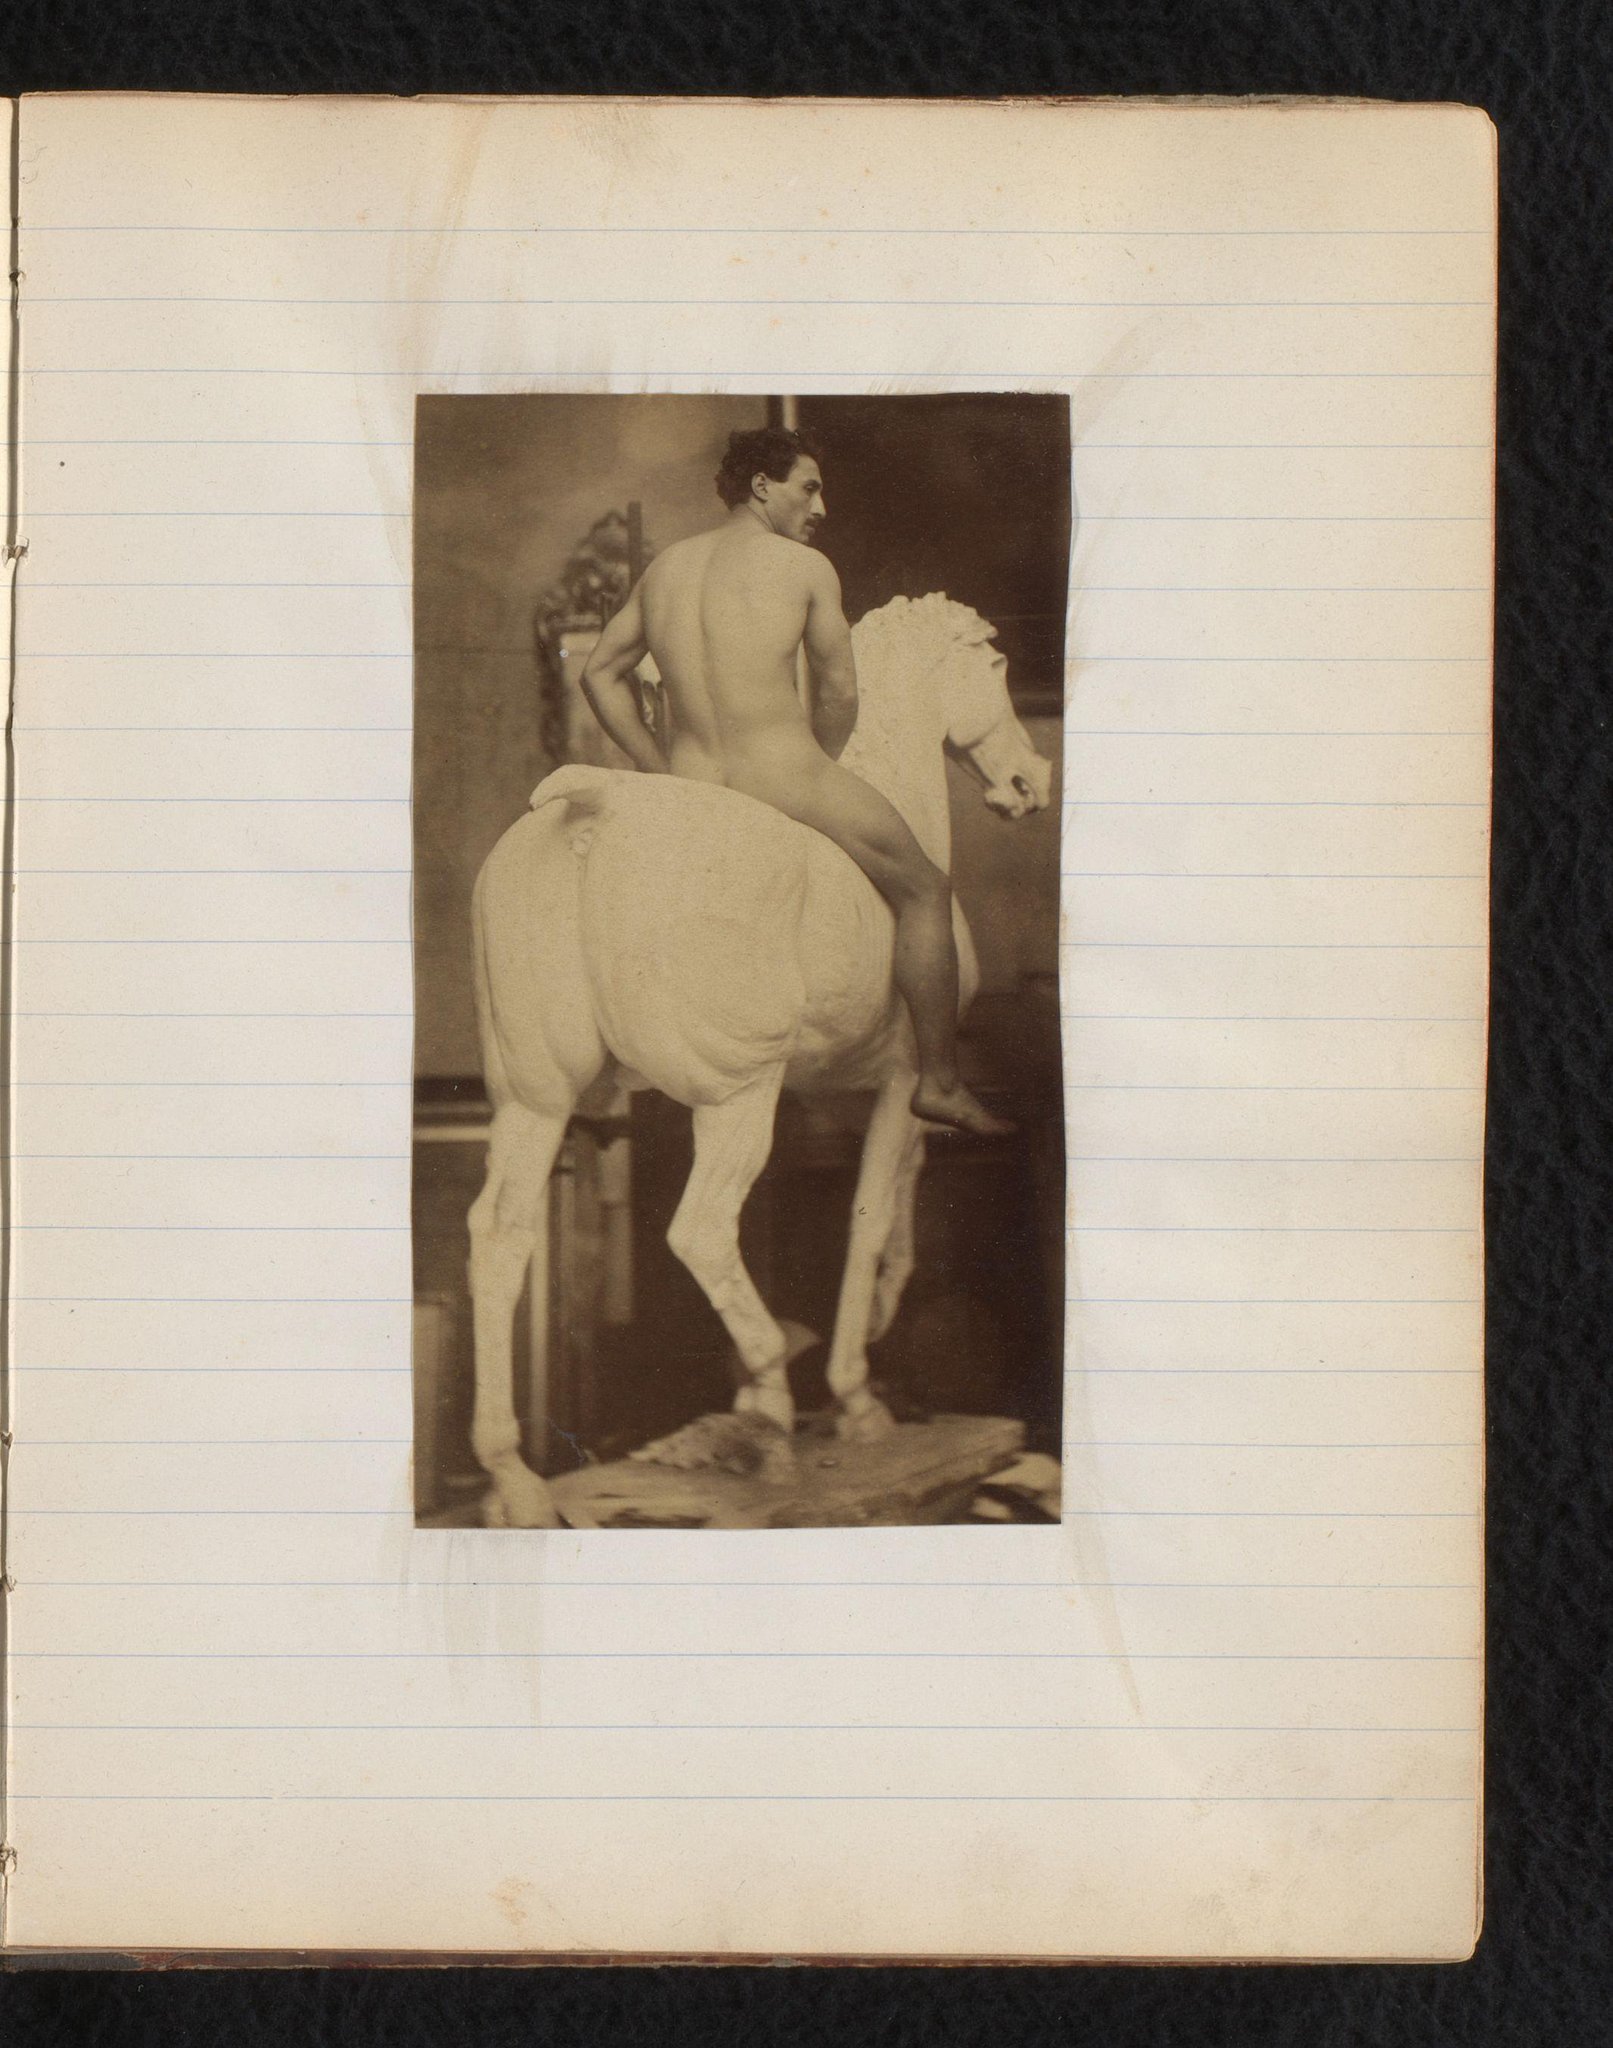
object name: album leaf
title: Studie van een mannelijk naaktmodel, gezeten op een gipsen paard, in het atelier van Jacques de Lalaing, mogelijk voorstudie voor Ruiterportret, Museum voor Schone Kunsten Gent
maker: jacques lalaing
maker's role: painter, sculptor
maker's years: 1858-1917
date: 1883-1914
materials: photographic support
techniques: albumen print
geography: brussels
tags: adult man, sculpture, artist (in general) working from nude model